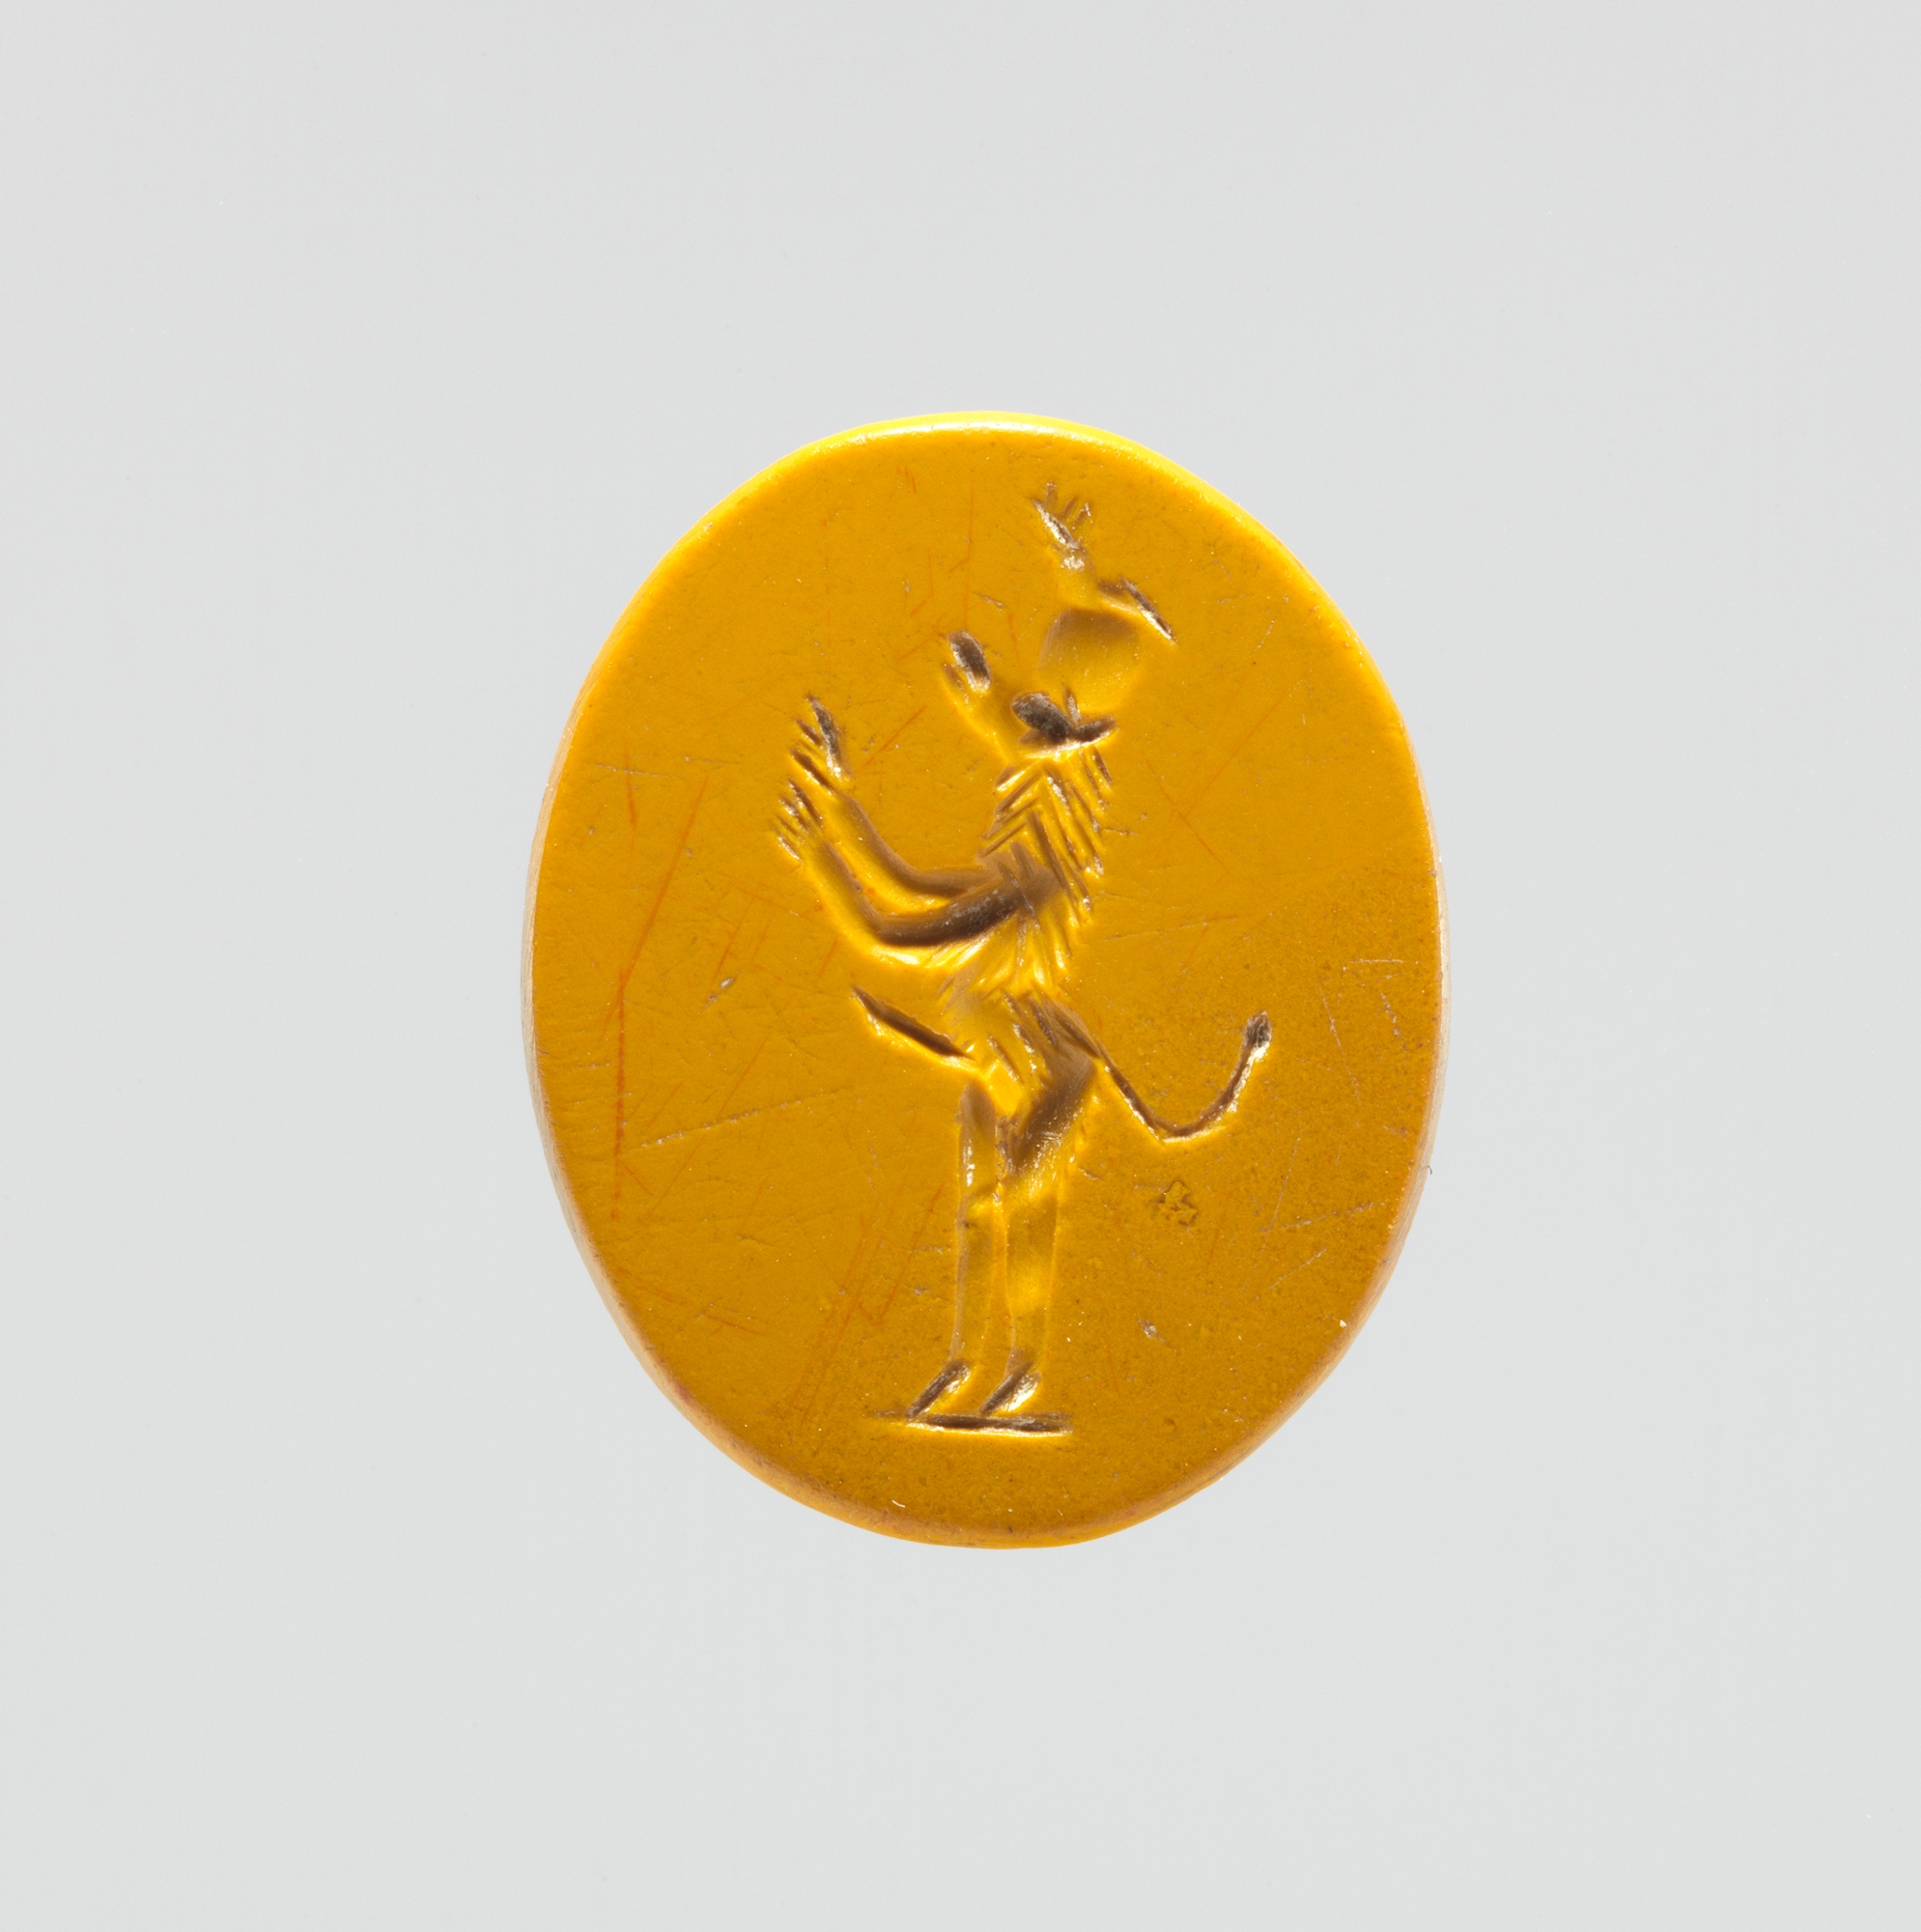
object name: intaglio, magical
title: Jasper intaglio: Cynocephalus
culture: roman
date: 101-300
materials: jasper